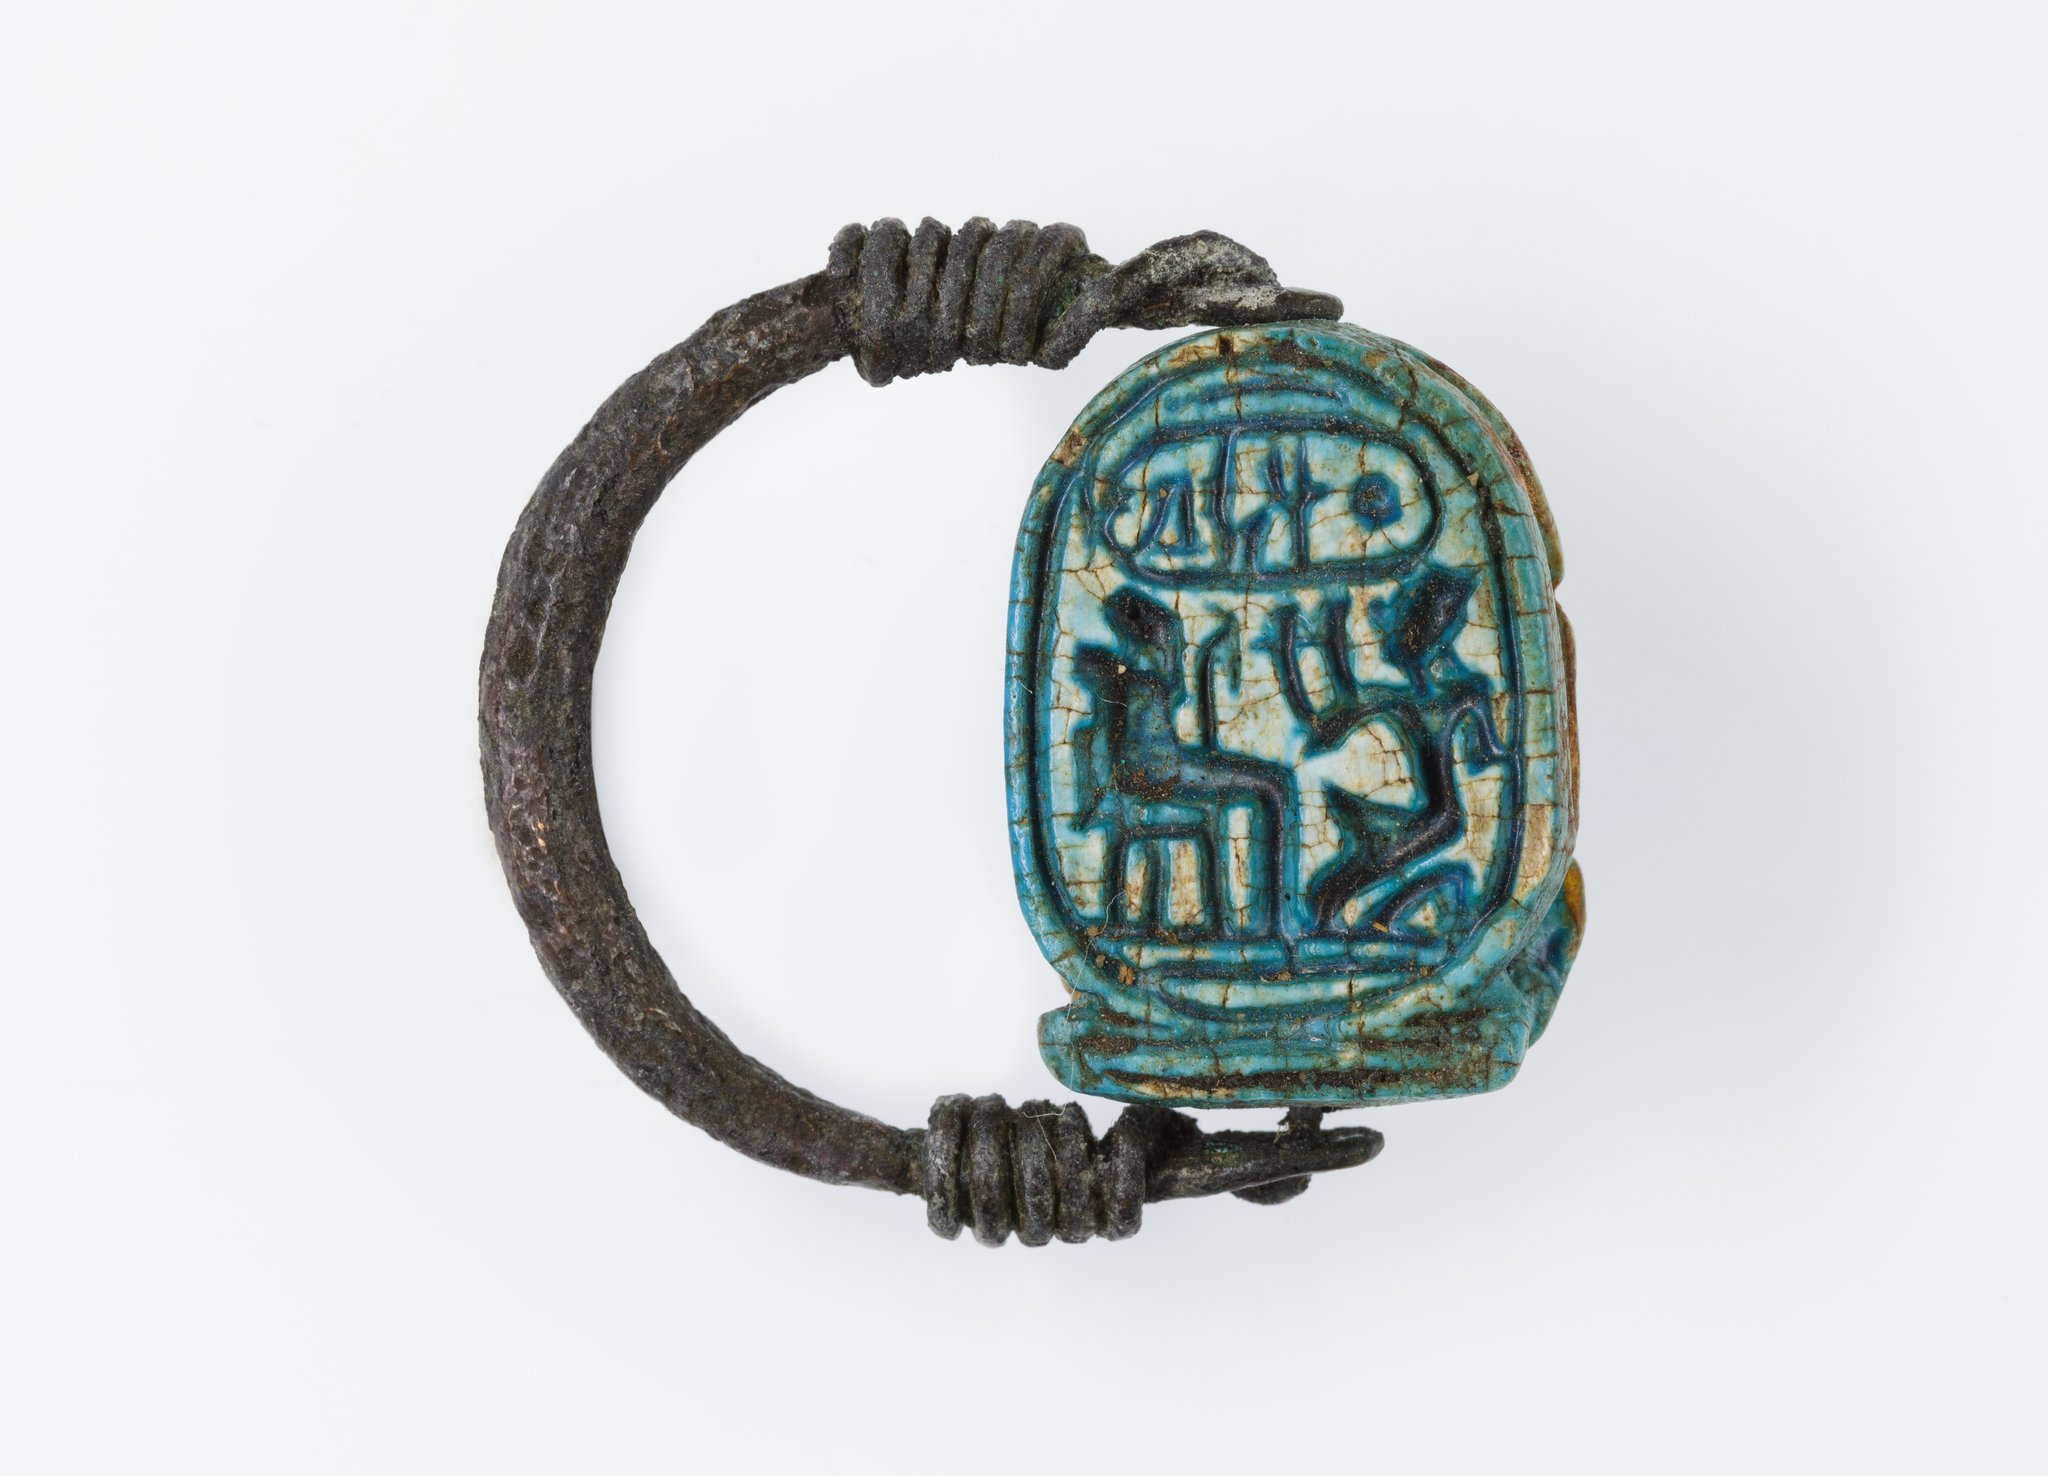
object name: ring, scarab, ramesses ii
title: Scarab Finger Ring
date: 1279-1213 BCE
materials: bronze, copper alloy, stone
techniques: glazing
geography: egypt